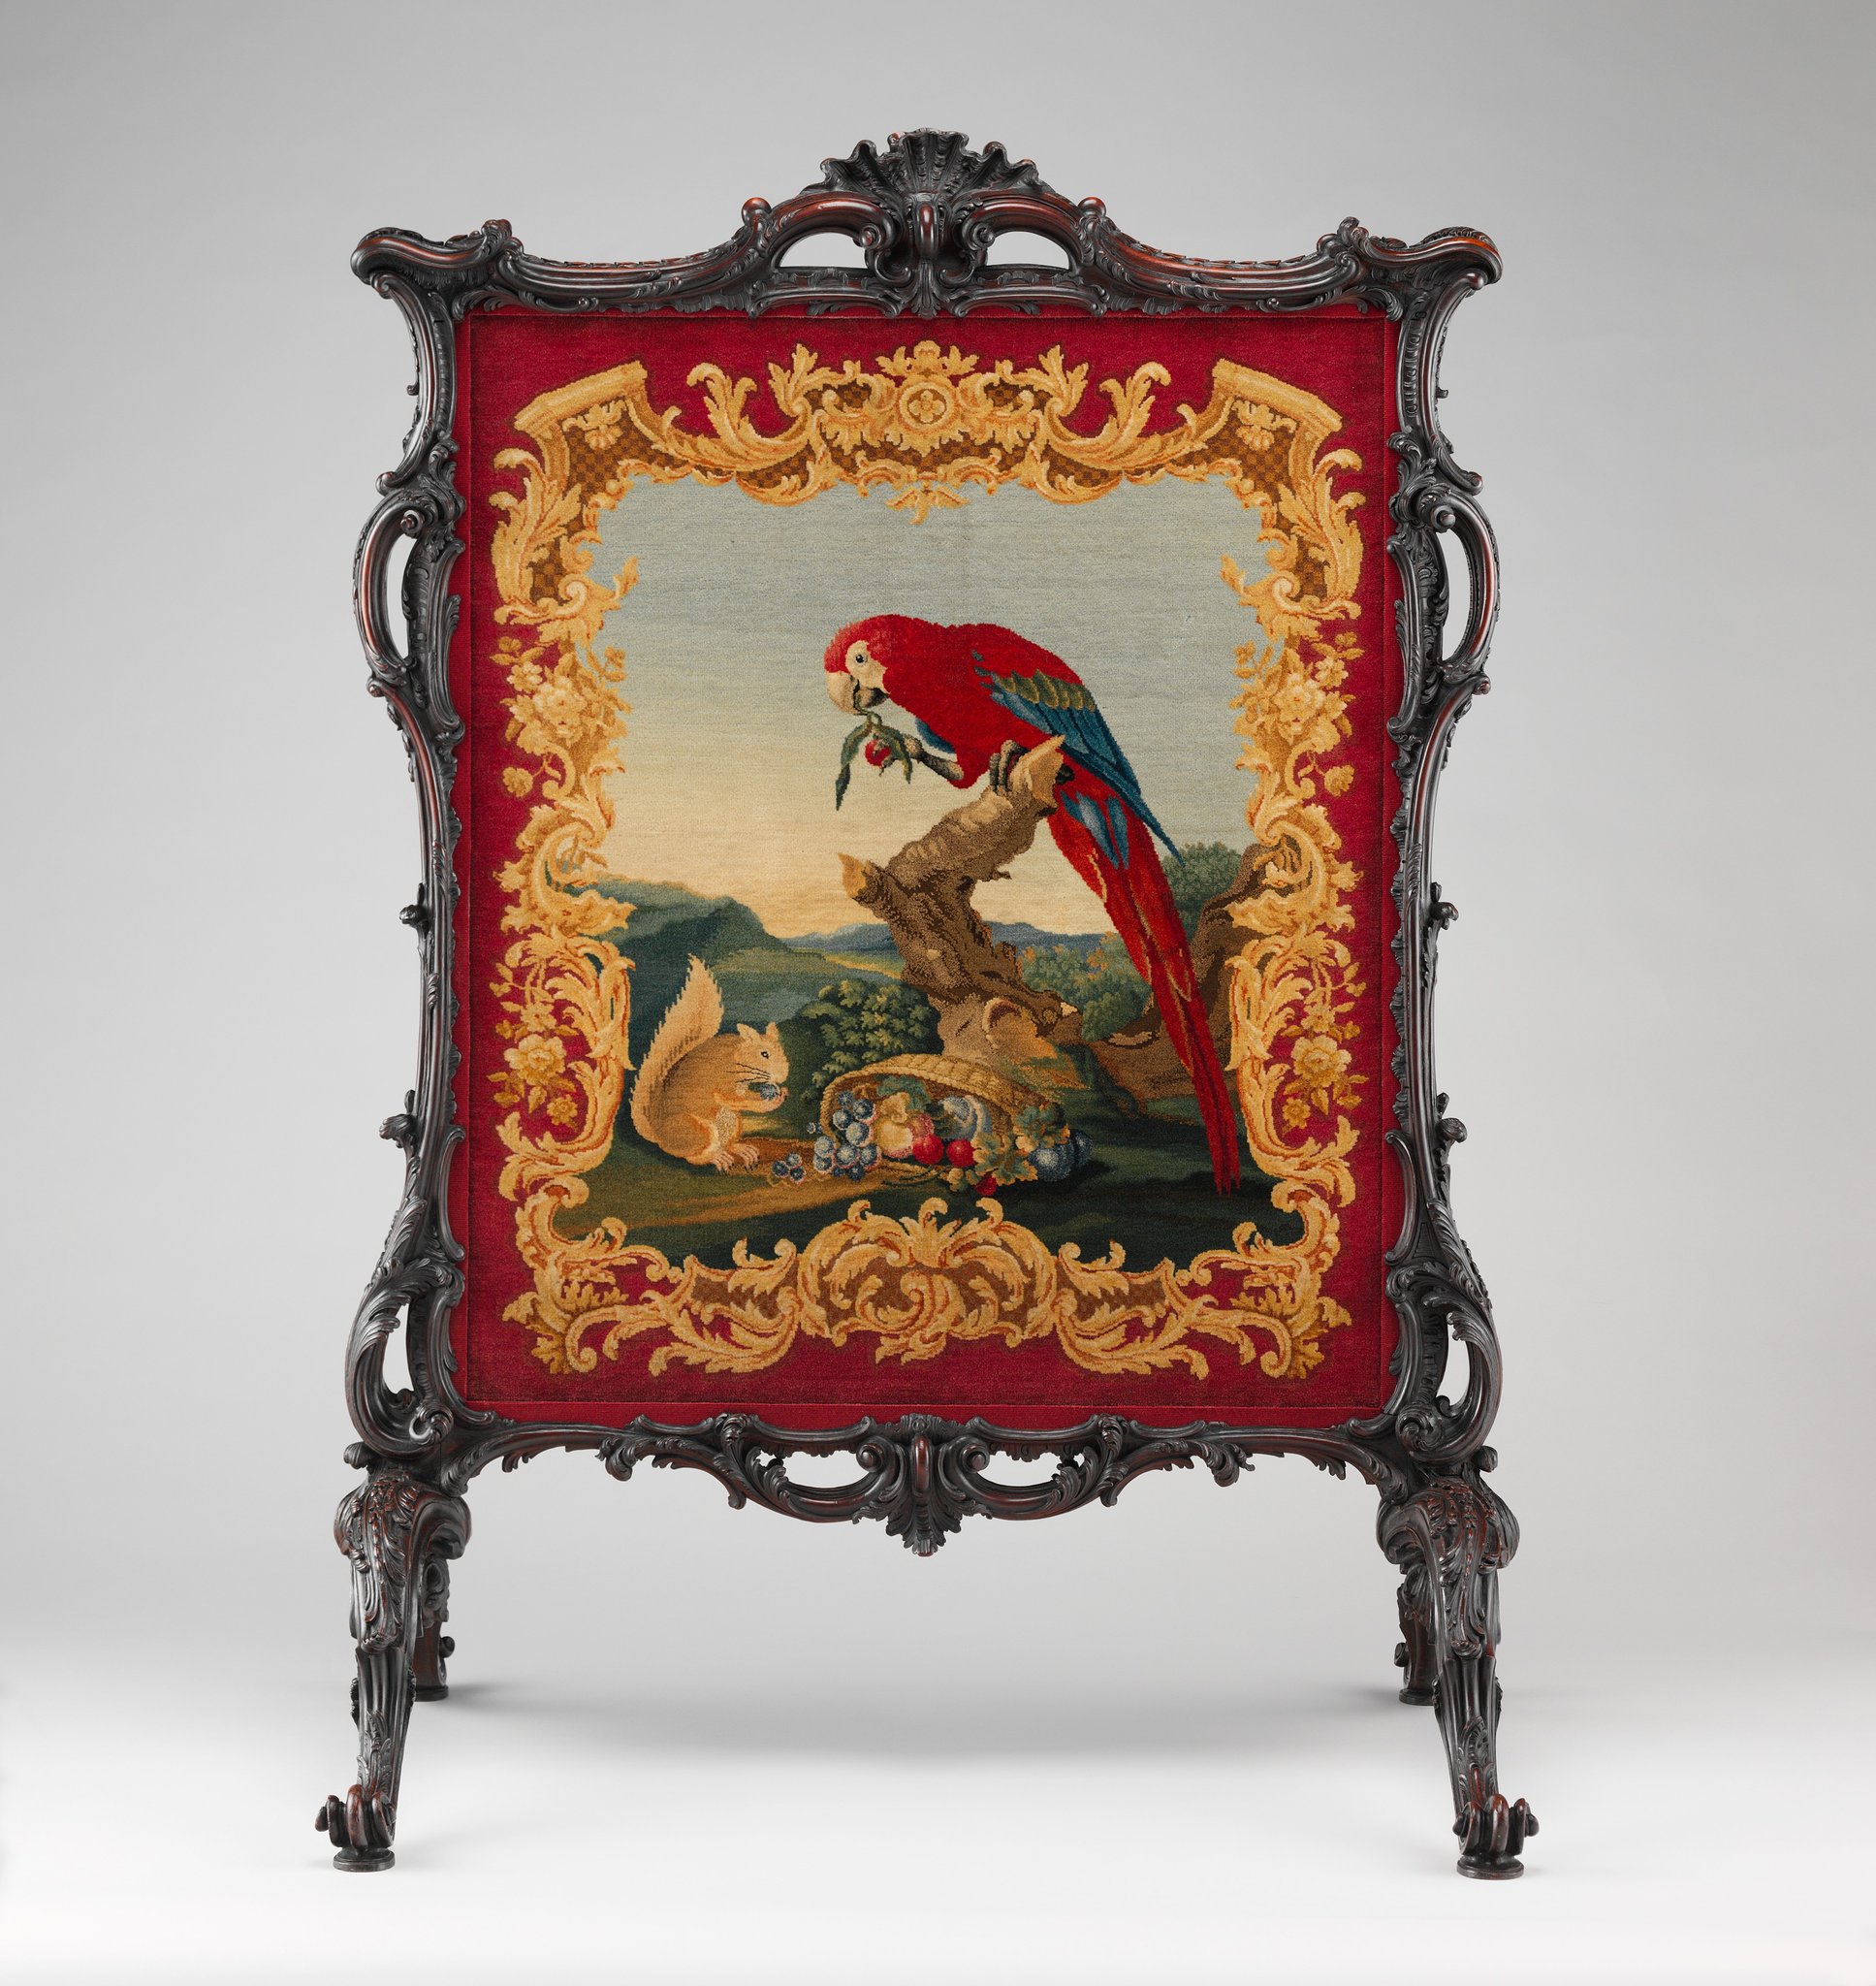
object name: cheval fire screen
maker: thomas moore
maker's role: maker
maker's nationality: british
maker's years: 1695-1788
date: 1755-1760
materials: wood, panel, wool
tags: fruit,parrots,squirrels